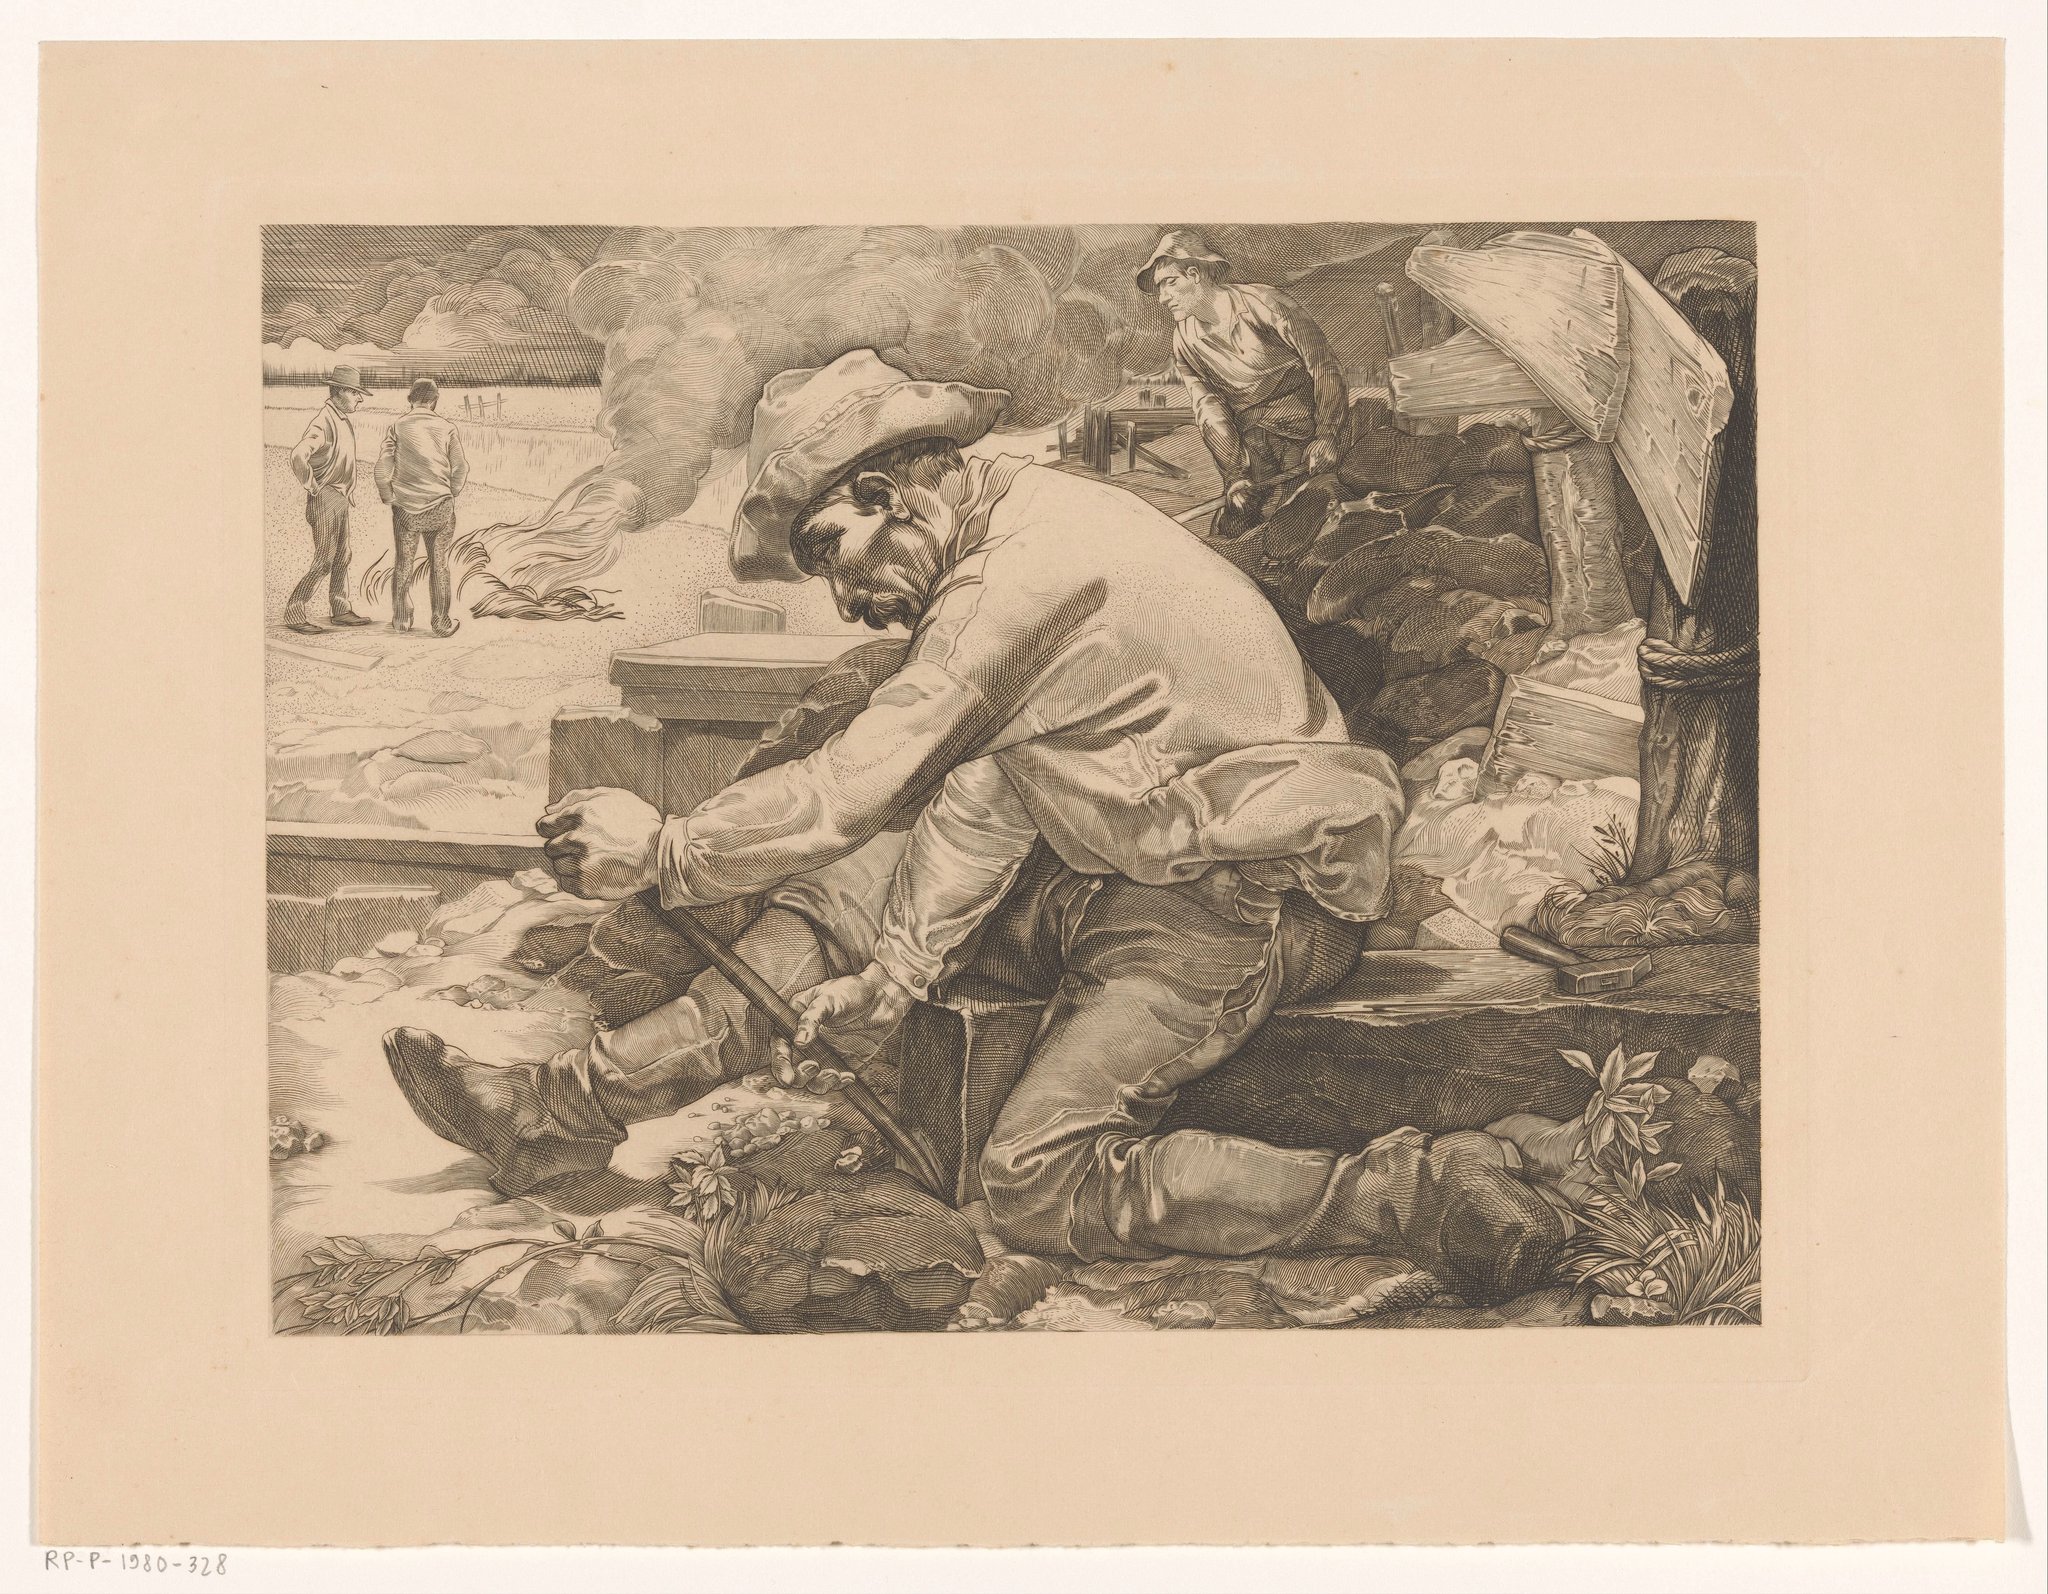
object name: print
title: Wrikkende arbeider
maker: johannes josephus aarts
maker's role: draughtsman, print maker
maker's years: 1871-1934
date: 1900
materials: paper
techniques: engraving, intaglio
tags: open fire (in general), working class, labourers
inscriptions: collector's mark: Lugt 2228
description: Een arbeider wrikt met een staaf onder een balk. Op de achtergrond nog drie arbeiders, waarvan twee bij een vuur.